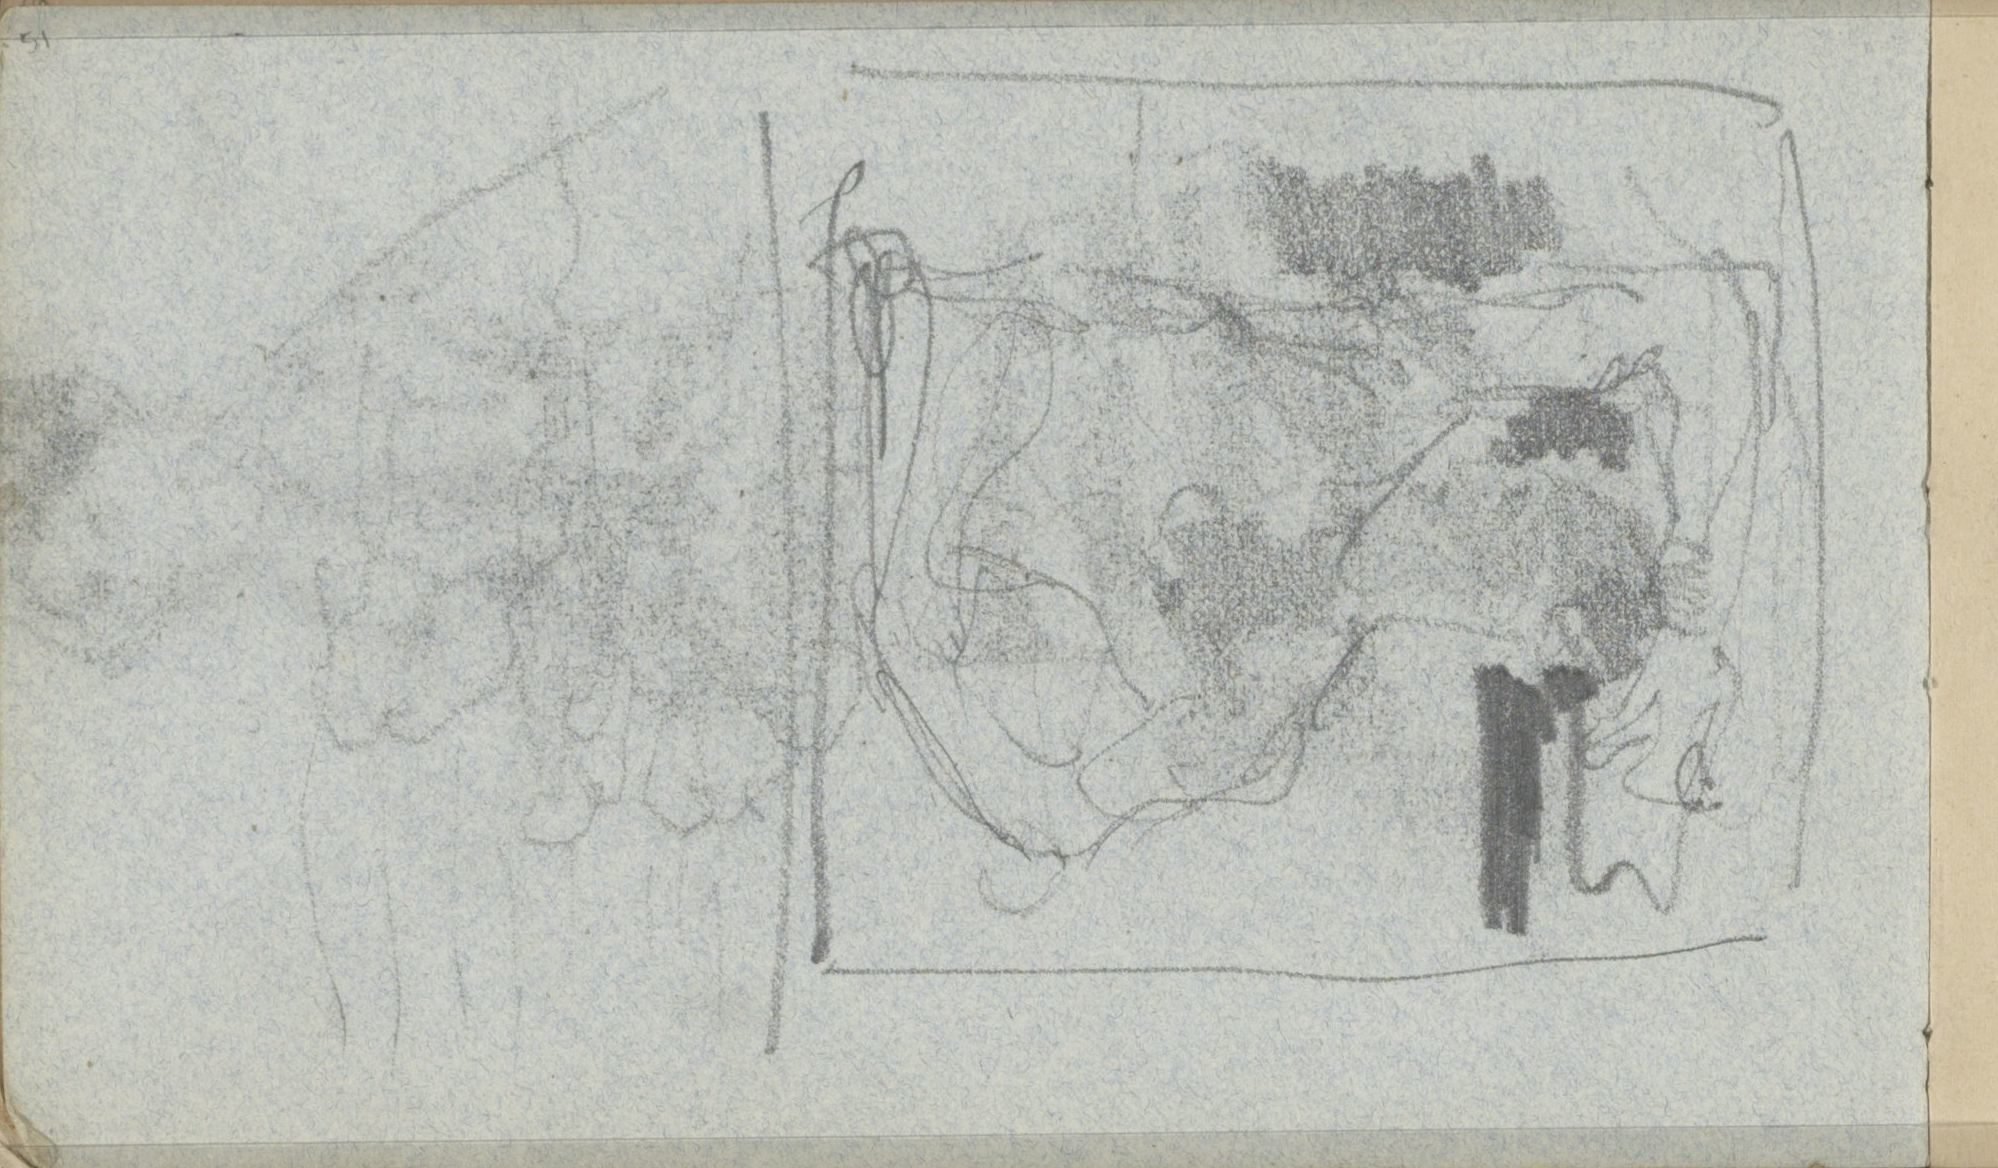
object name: sketchbook leaf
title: Vrouw en een compositiestudie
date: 1881-1883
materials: paper, pencil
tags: adult woman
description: Pagina 51 uit een schetsboek met 30 bladen.